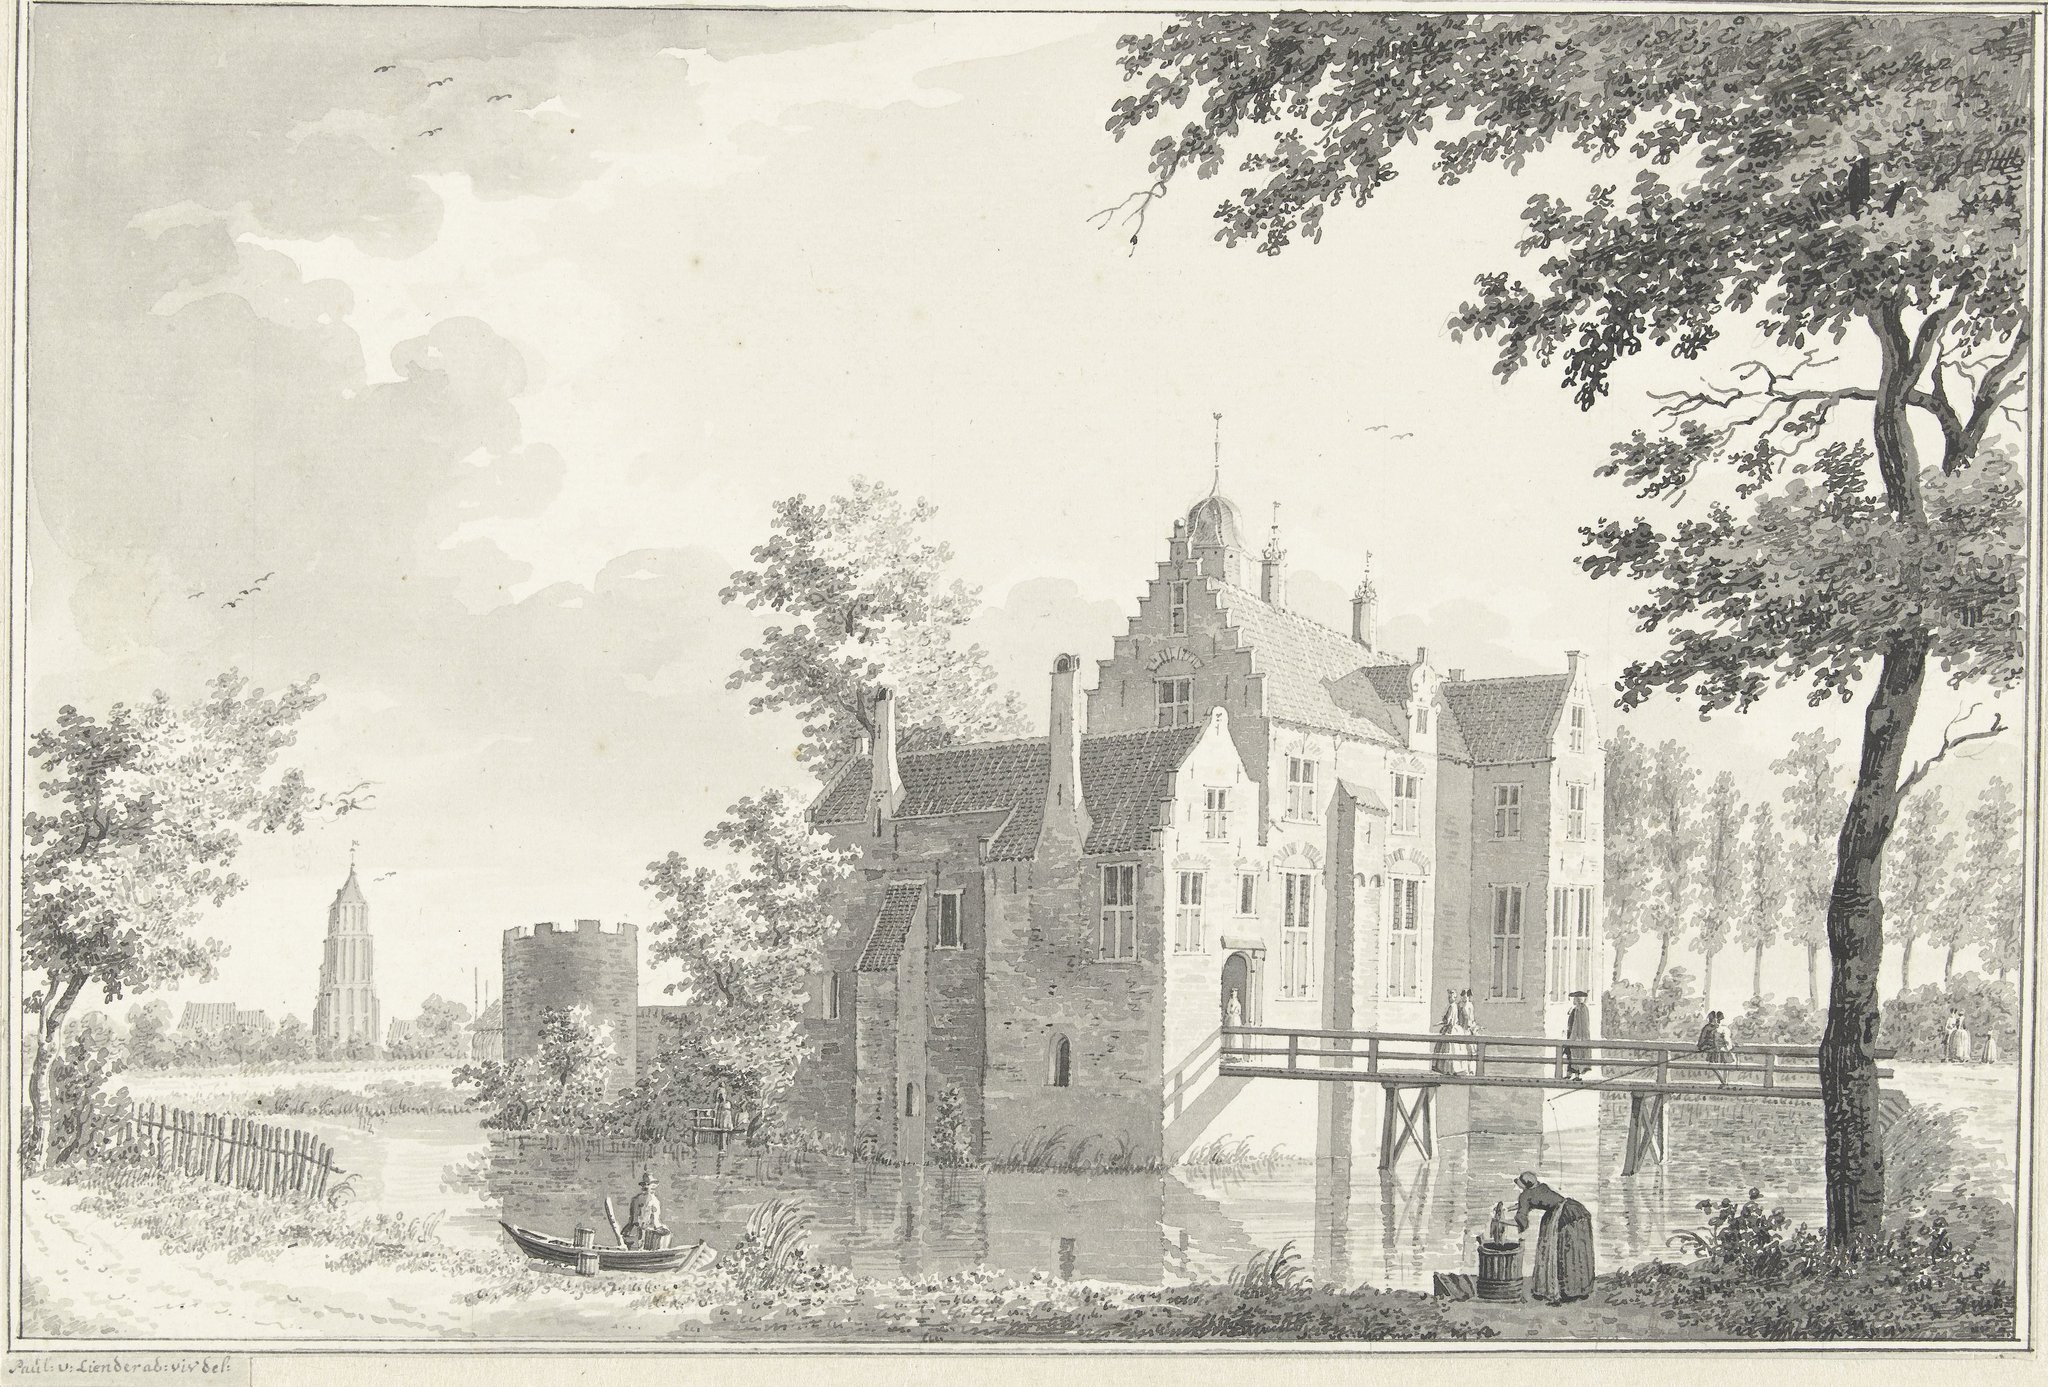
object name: drawing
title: Huis Oosterwyk, van achteren gezien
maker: paulus van liender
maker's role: draughtsman, print maker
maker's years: 1731-1797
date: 1750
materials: ink, paper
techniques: brush, pen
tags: castle